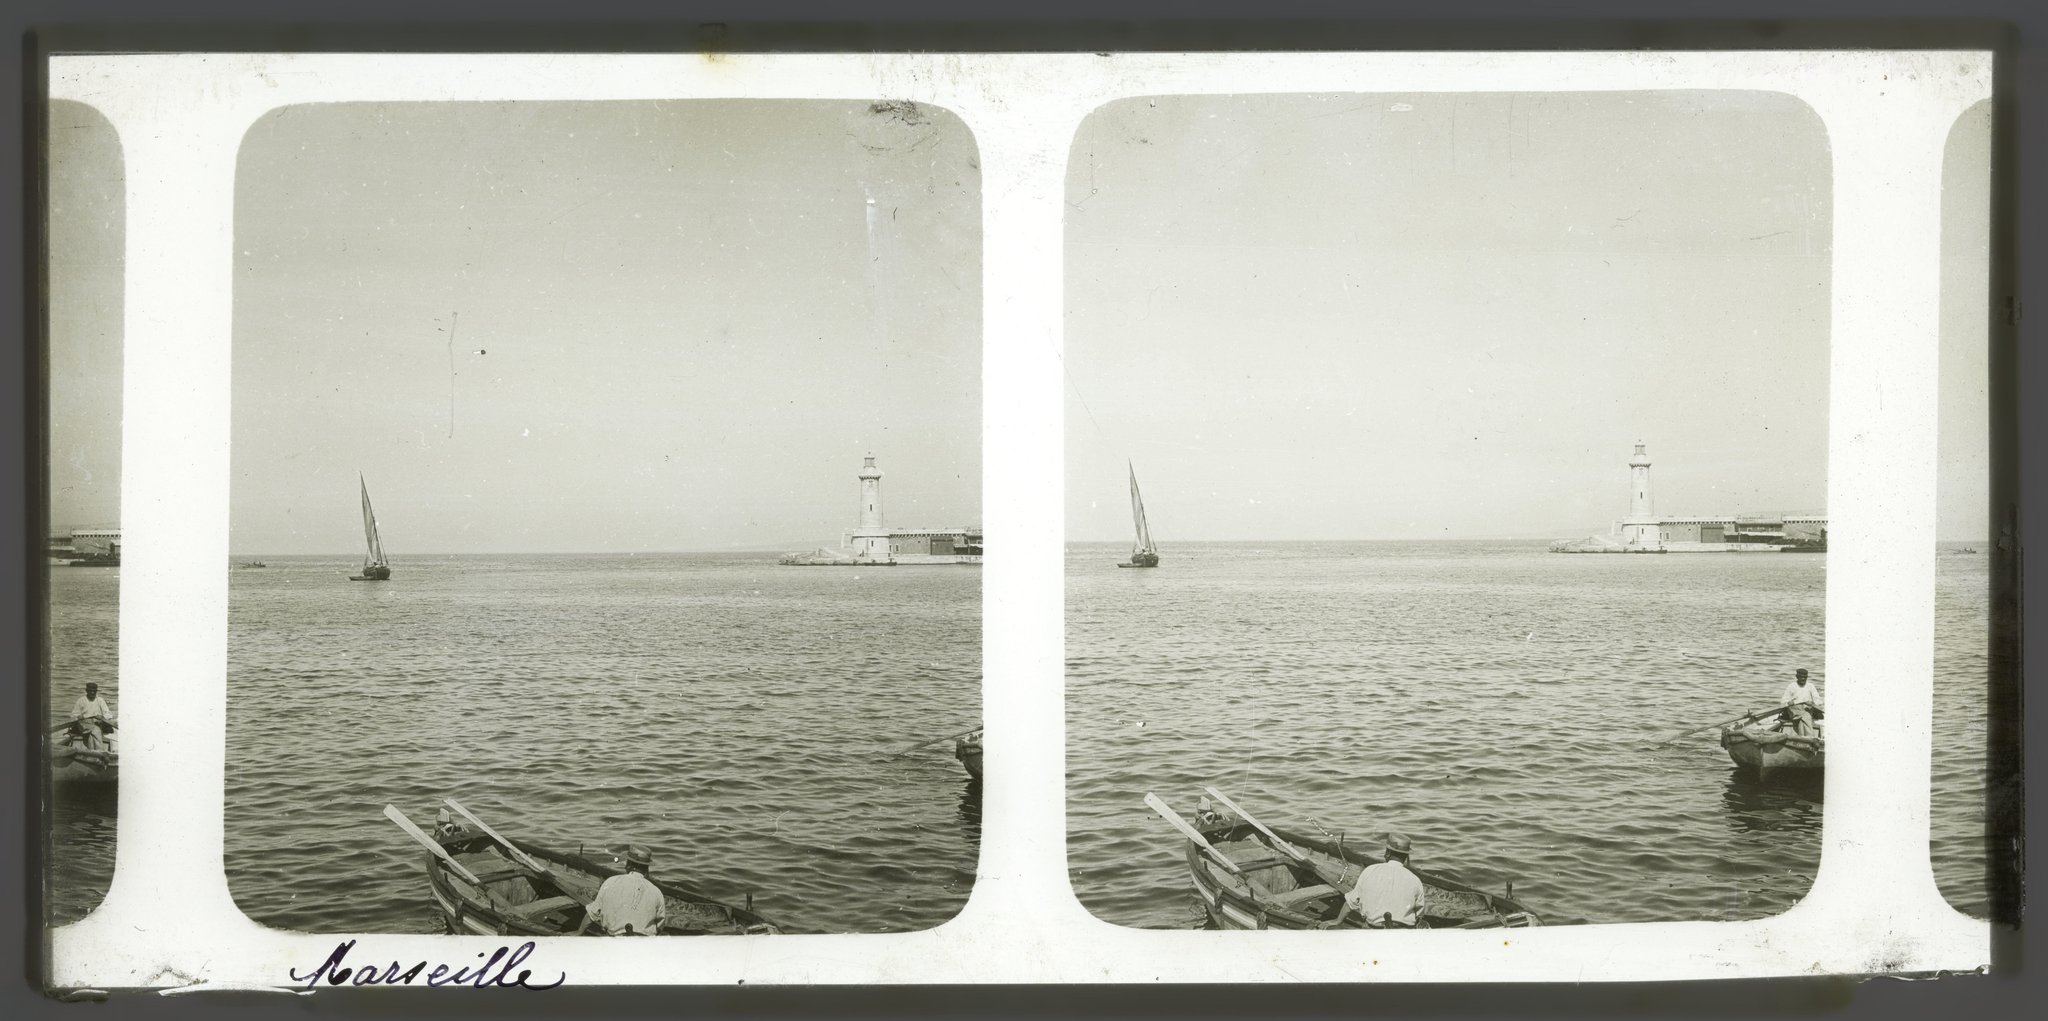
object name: stereograph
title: Marseille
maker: Anonymous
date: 1880-1900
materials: glass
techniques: slide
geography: marseille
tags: lighthouse, lightship, sailing-ship, sailing-boat, rowing facing backward, pulling, marseille